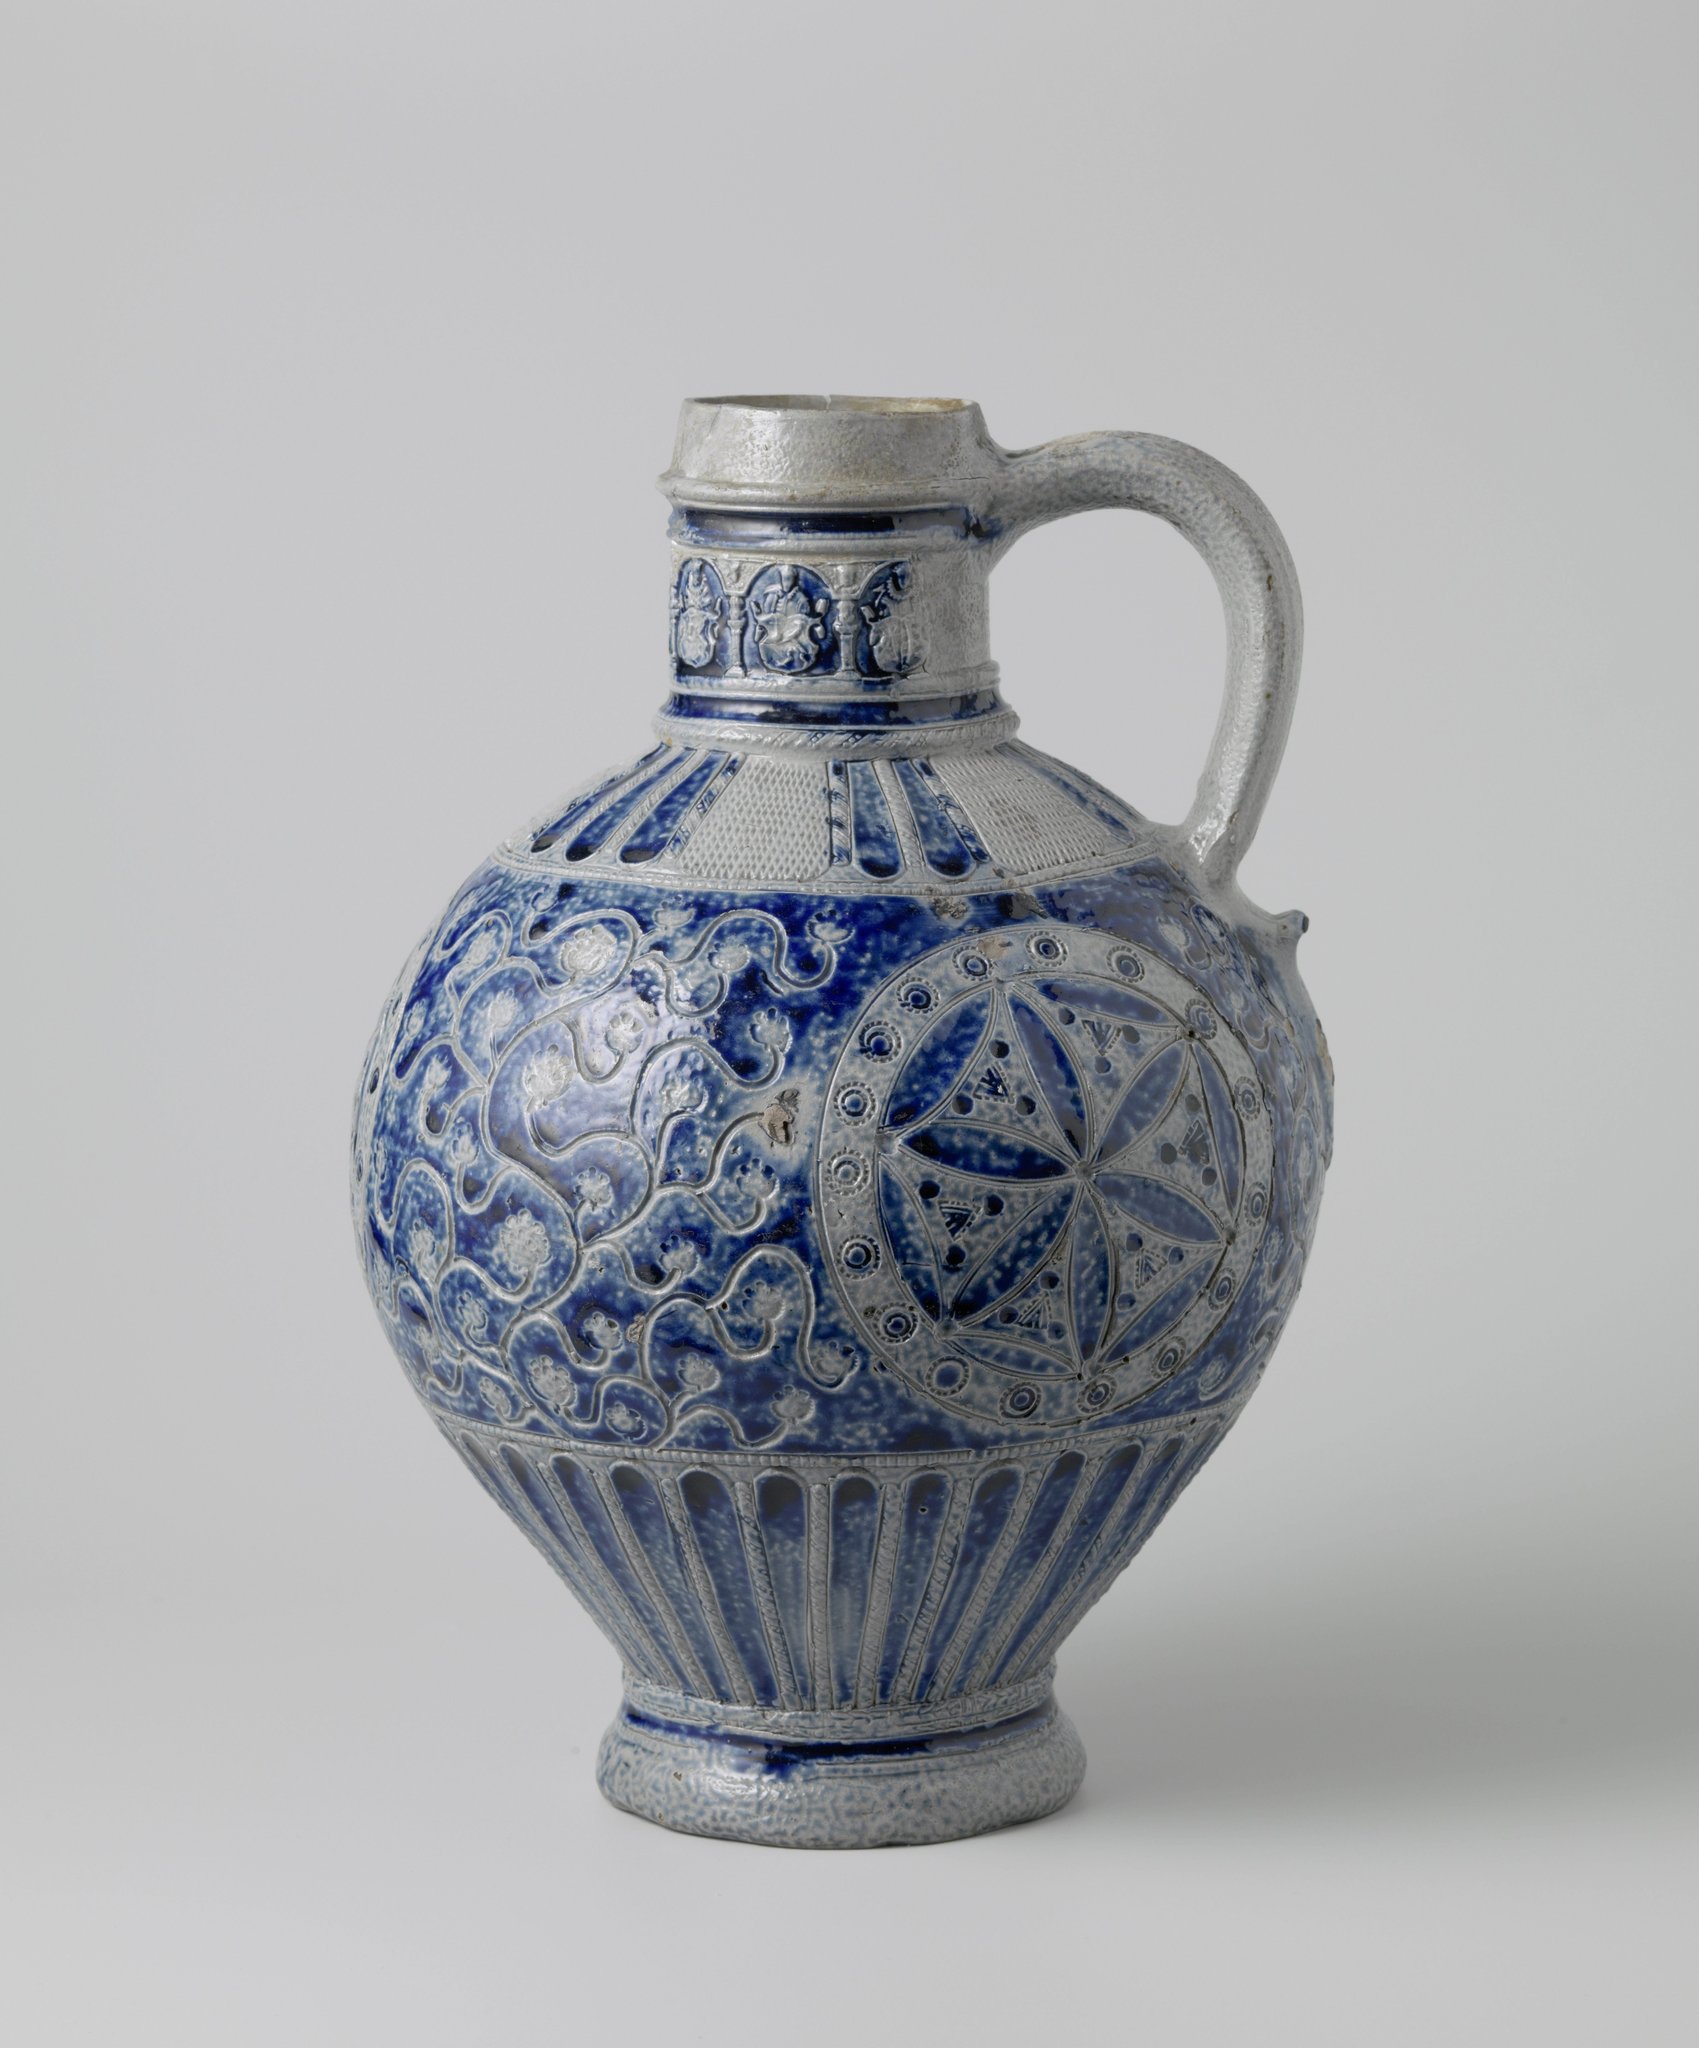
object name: jug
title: Jug with the electors, medallions and floral scrolls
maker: Anonymous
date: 1600-1620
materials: cobalt, glaze, stoneware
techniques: printing, firing, forming, relief, turning, vitrification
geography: raeren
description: Kruik van steengoed op hoge voet met een eivormig lichaam en korte, wijde nek. Het C-vormige oor is bevestigd aan de nek en de schouder. Profielen op de nek en voet. Gedeeltelijk bedekt met kobaltblauw. Op de buik een brede band met ingegrifte ranken met gestempelde bloemen, onderbroken door medaillons met een bloemrozet. Het onderste deel van de buik met een band canelures. Op de schouder een band met canelures, afgewisseld met vakken kerfsnede. De nek met in reliëf een gedrukte en opgelegde band met zes keurvorsten en hun wapens. Raeren.